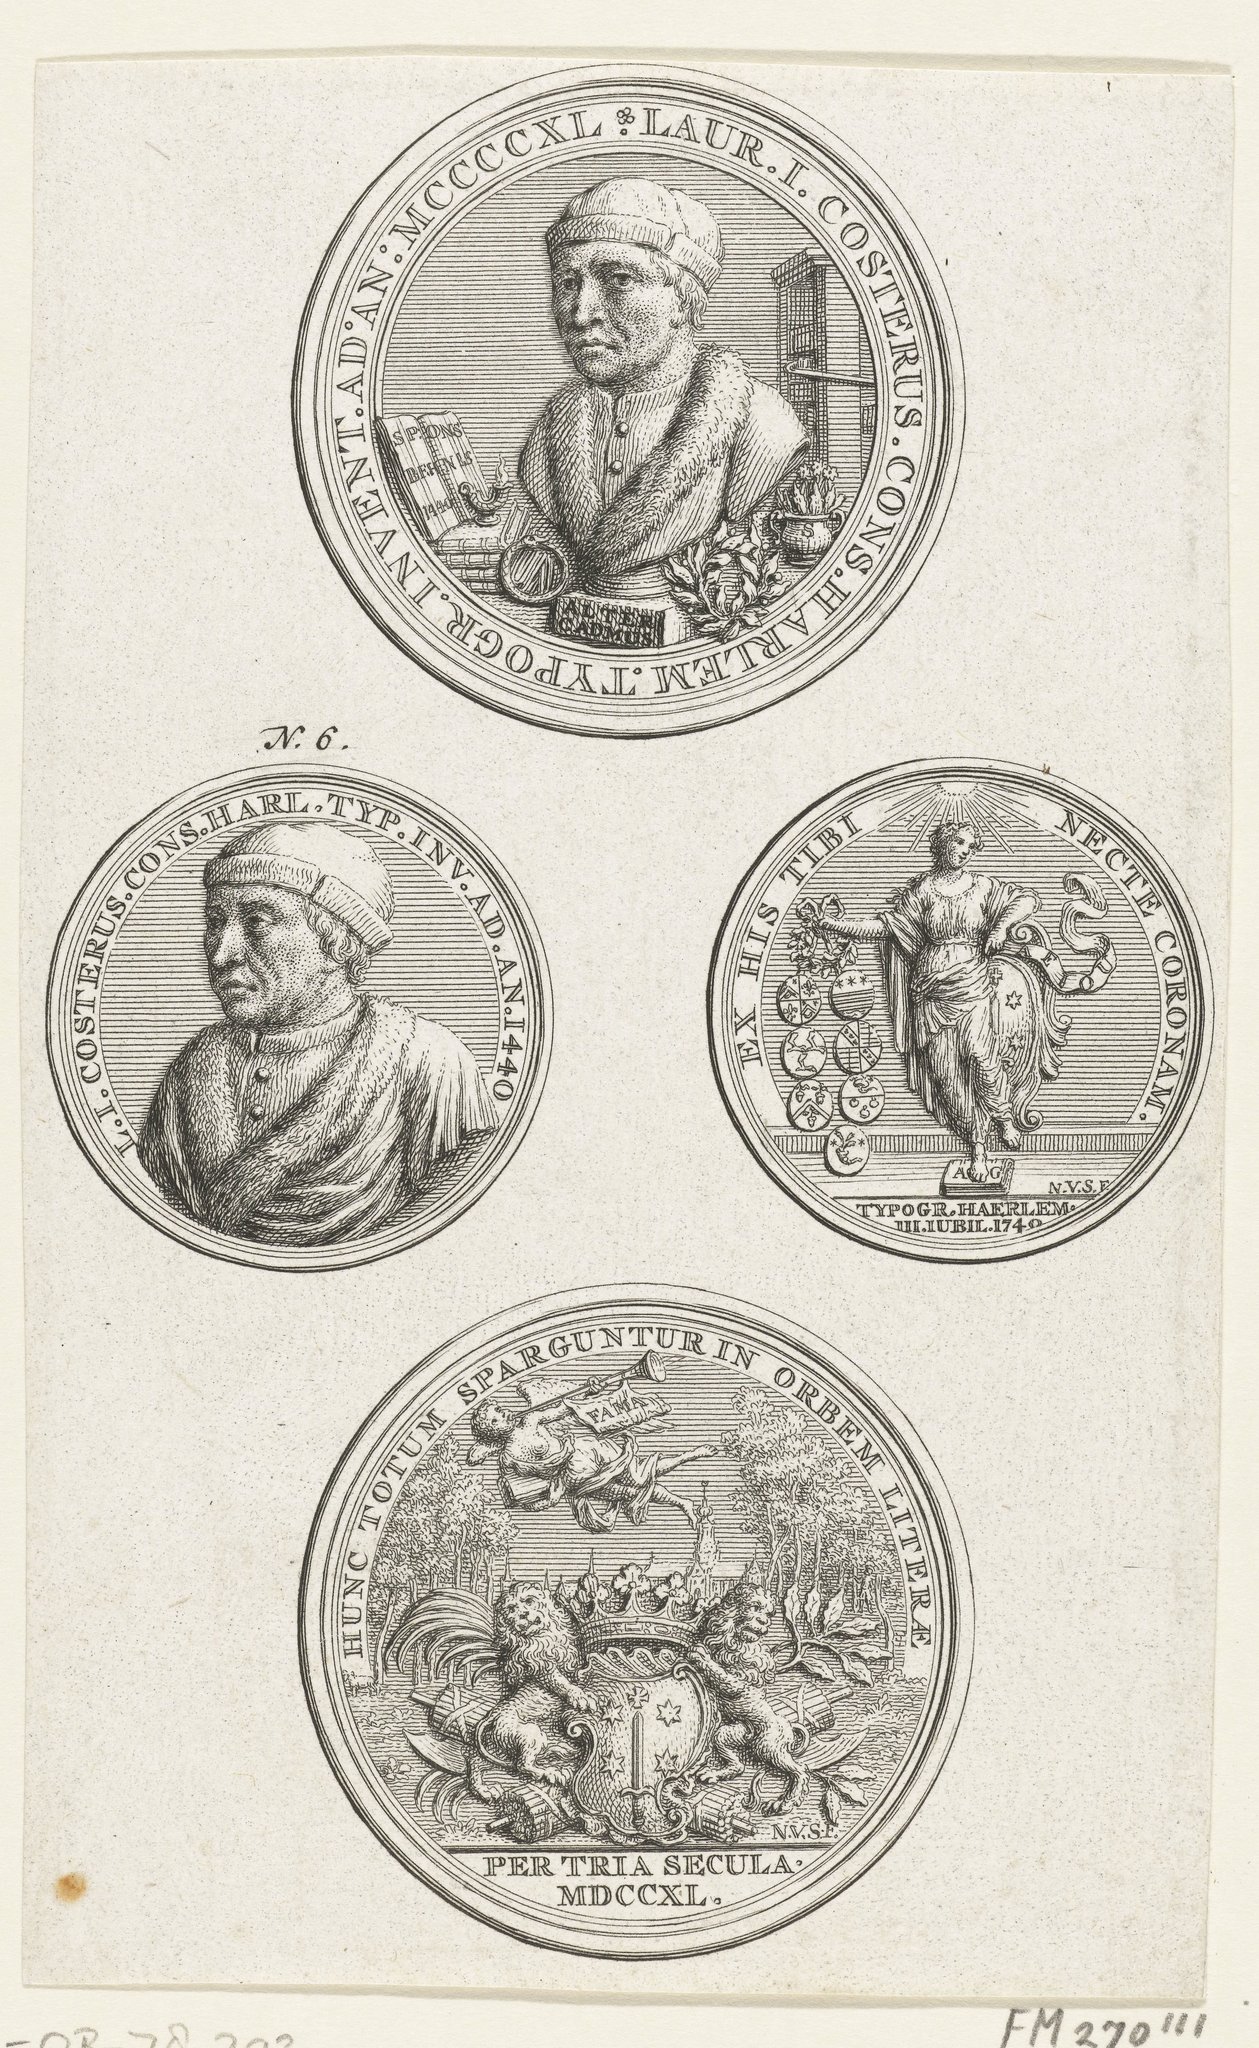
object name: historical object representation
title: Penningen ter gelegenheid van het derde eeuwfeest van de uitvinding van de boekdrukkunst in 1740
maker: Anonymous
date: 1738-1740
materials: paper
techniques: etching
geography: northern netherlands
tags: haarlem, medal (considered as a piece of sculpture, regardless of its specific function), printing, printing office, burgundian netherlands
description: Twee penningen, voor- en achterzijde, geslagen in 1740 ter gelegenheid van het derde eeuwfeest van de uitvinding van de boekdrukkunst. Afbeeldingen van Laurens Jansz. Coster en allegorieën op de boekdrukkunst.